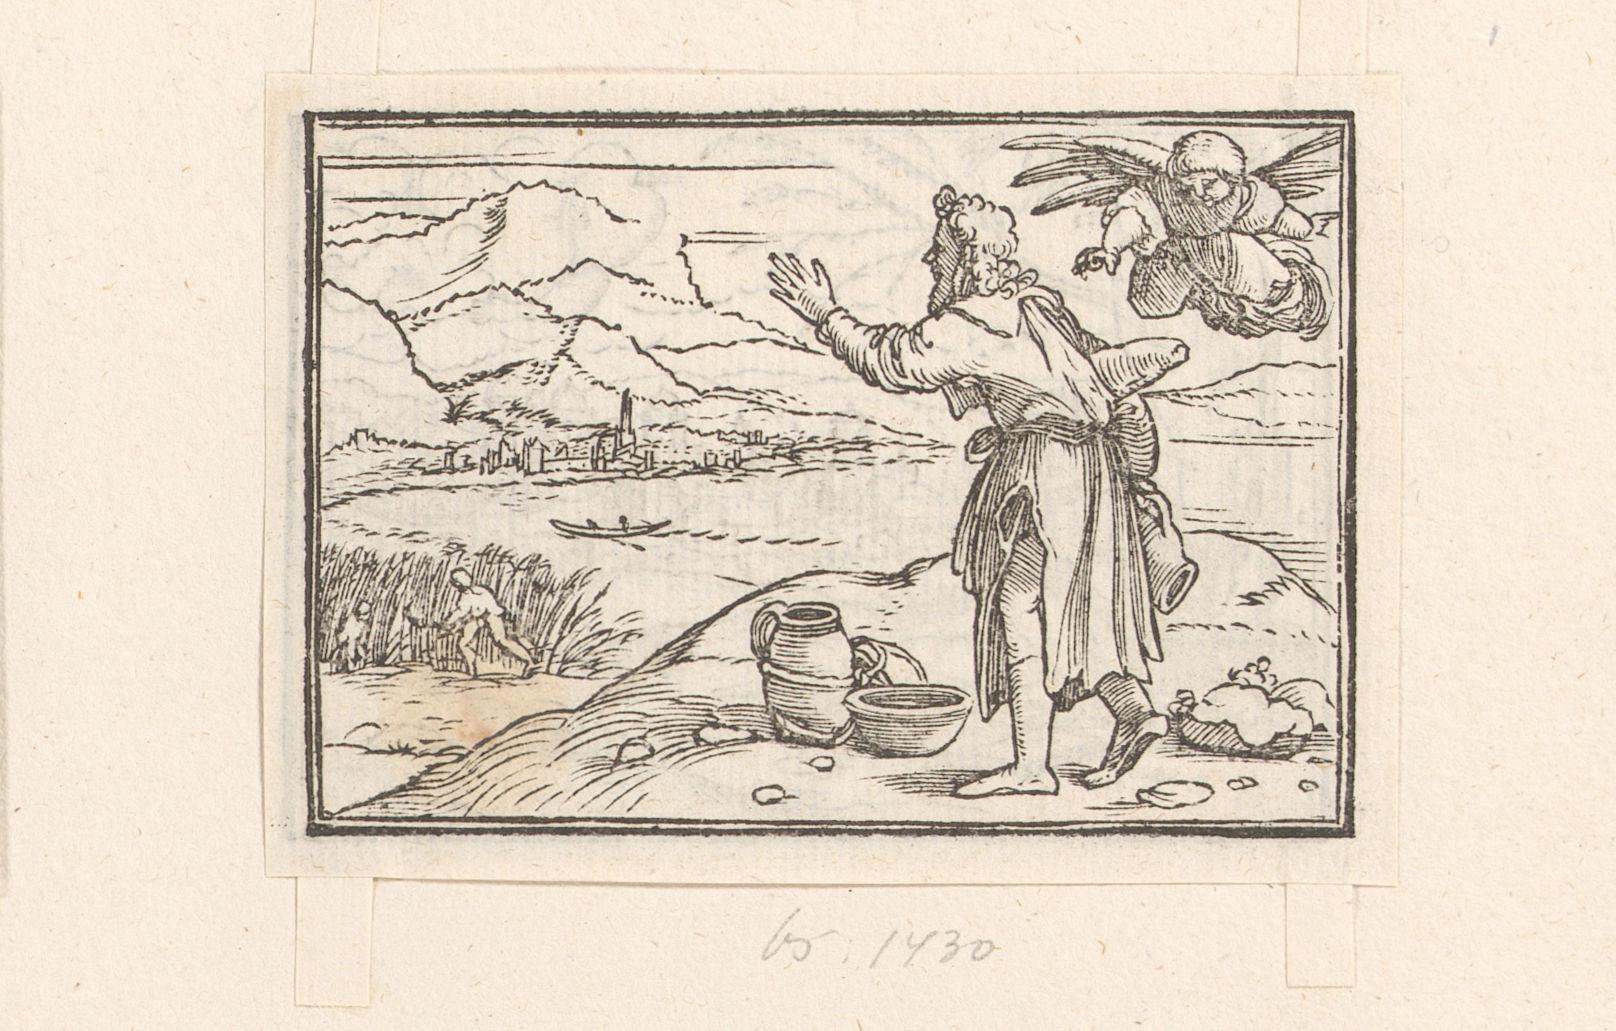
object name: book illustration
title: Geschiedenis van het Oude Testament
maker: veit rudolf specklin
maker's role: print maker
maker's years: -1550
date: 1538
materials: paper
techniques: woodcut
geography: switzerland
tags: habakkuk's prophecies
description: Habakuk brengt eten voor de maaiers op het veld. Een engel zweeft naast hem. In de marge boven de afbeelding staat de tekst Habacvc I. Deze illustratie lijkt meer van toepassing op het moment in de bijbel dat Habakuk van de engel het verzoek krijgt om mee te gaan naar Daniël in de leeuwenkuil. Prent maakt deel uit van een album.